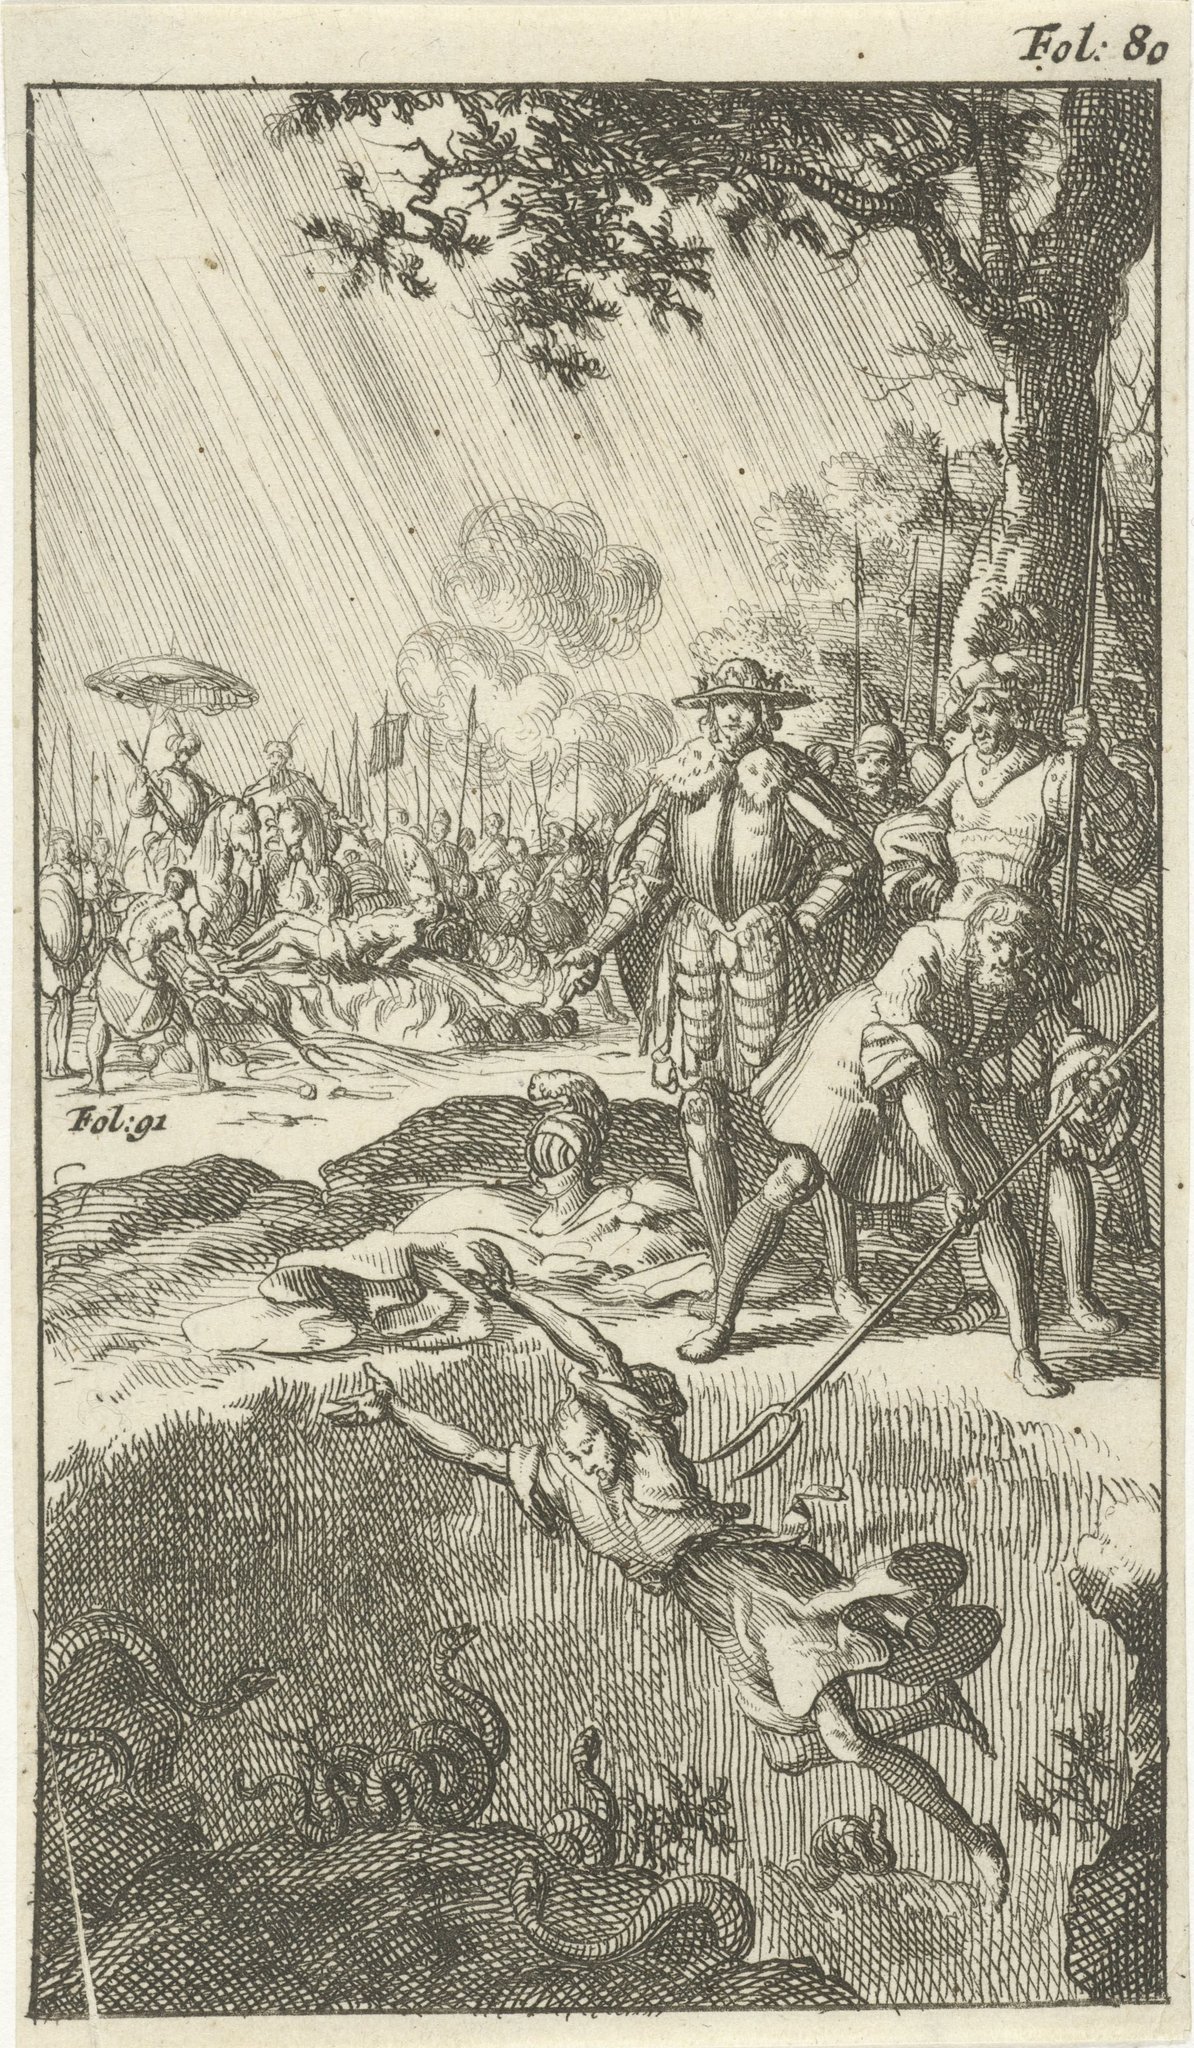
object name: print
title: Regner, koning der Denen, gevangen genomen en in een kuil met adders geworpen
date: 1687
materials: paper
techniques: etching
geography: amsterdam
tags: pit, hole, king, snakes: viper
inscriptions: collector's mark: Lugt 2228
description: Illustratie uit: Ziegler, Georg. Konst-spiegel der weereltlikke vermaken. Amsterdam: Johannes Boekholt, 1687.